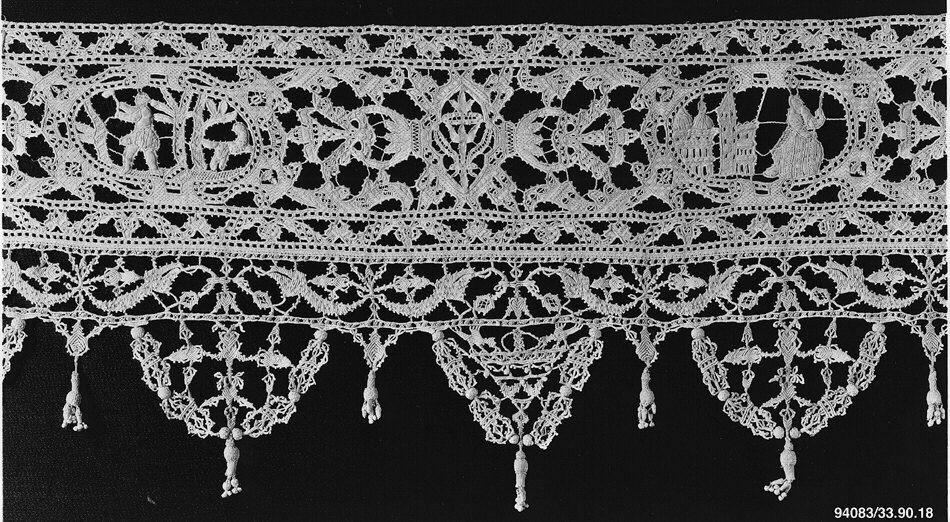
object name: border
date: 1601-1700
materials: linen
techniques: embroidery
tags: human figures